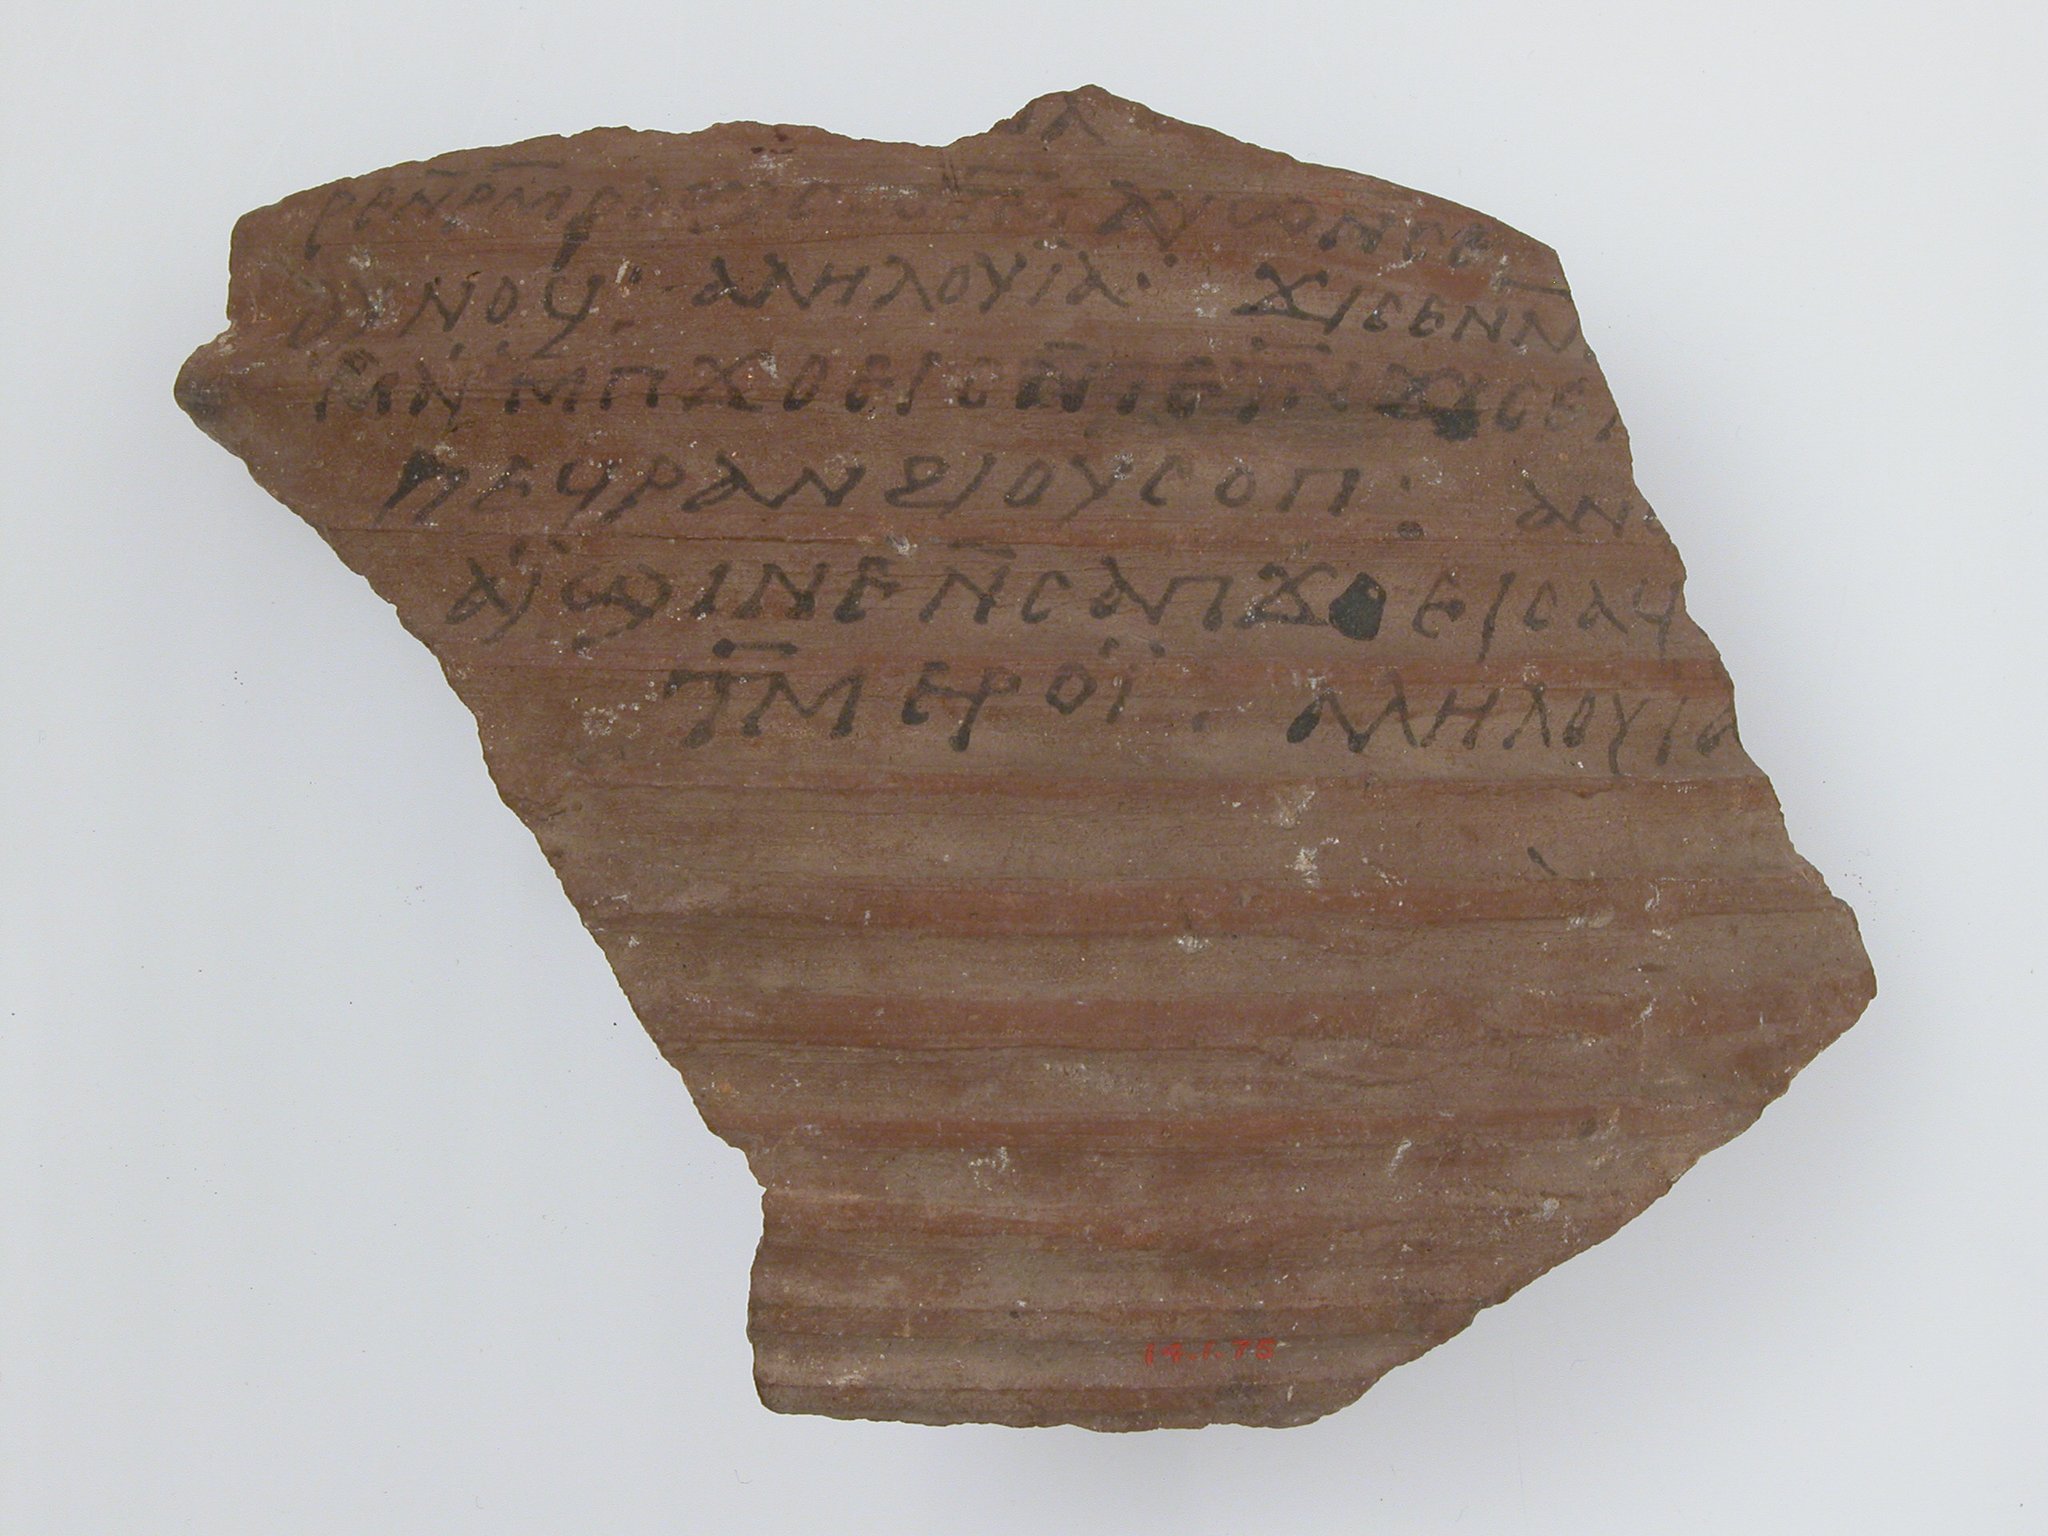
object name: ostrakon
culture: coptic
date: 600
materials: ink, pottery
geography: egypt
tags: coptic,documents